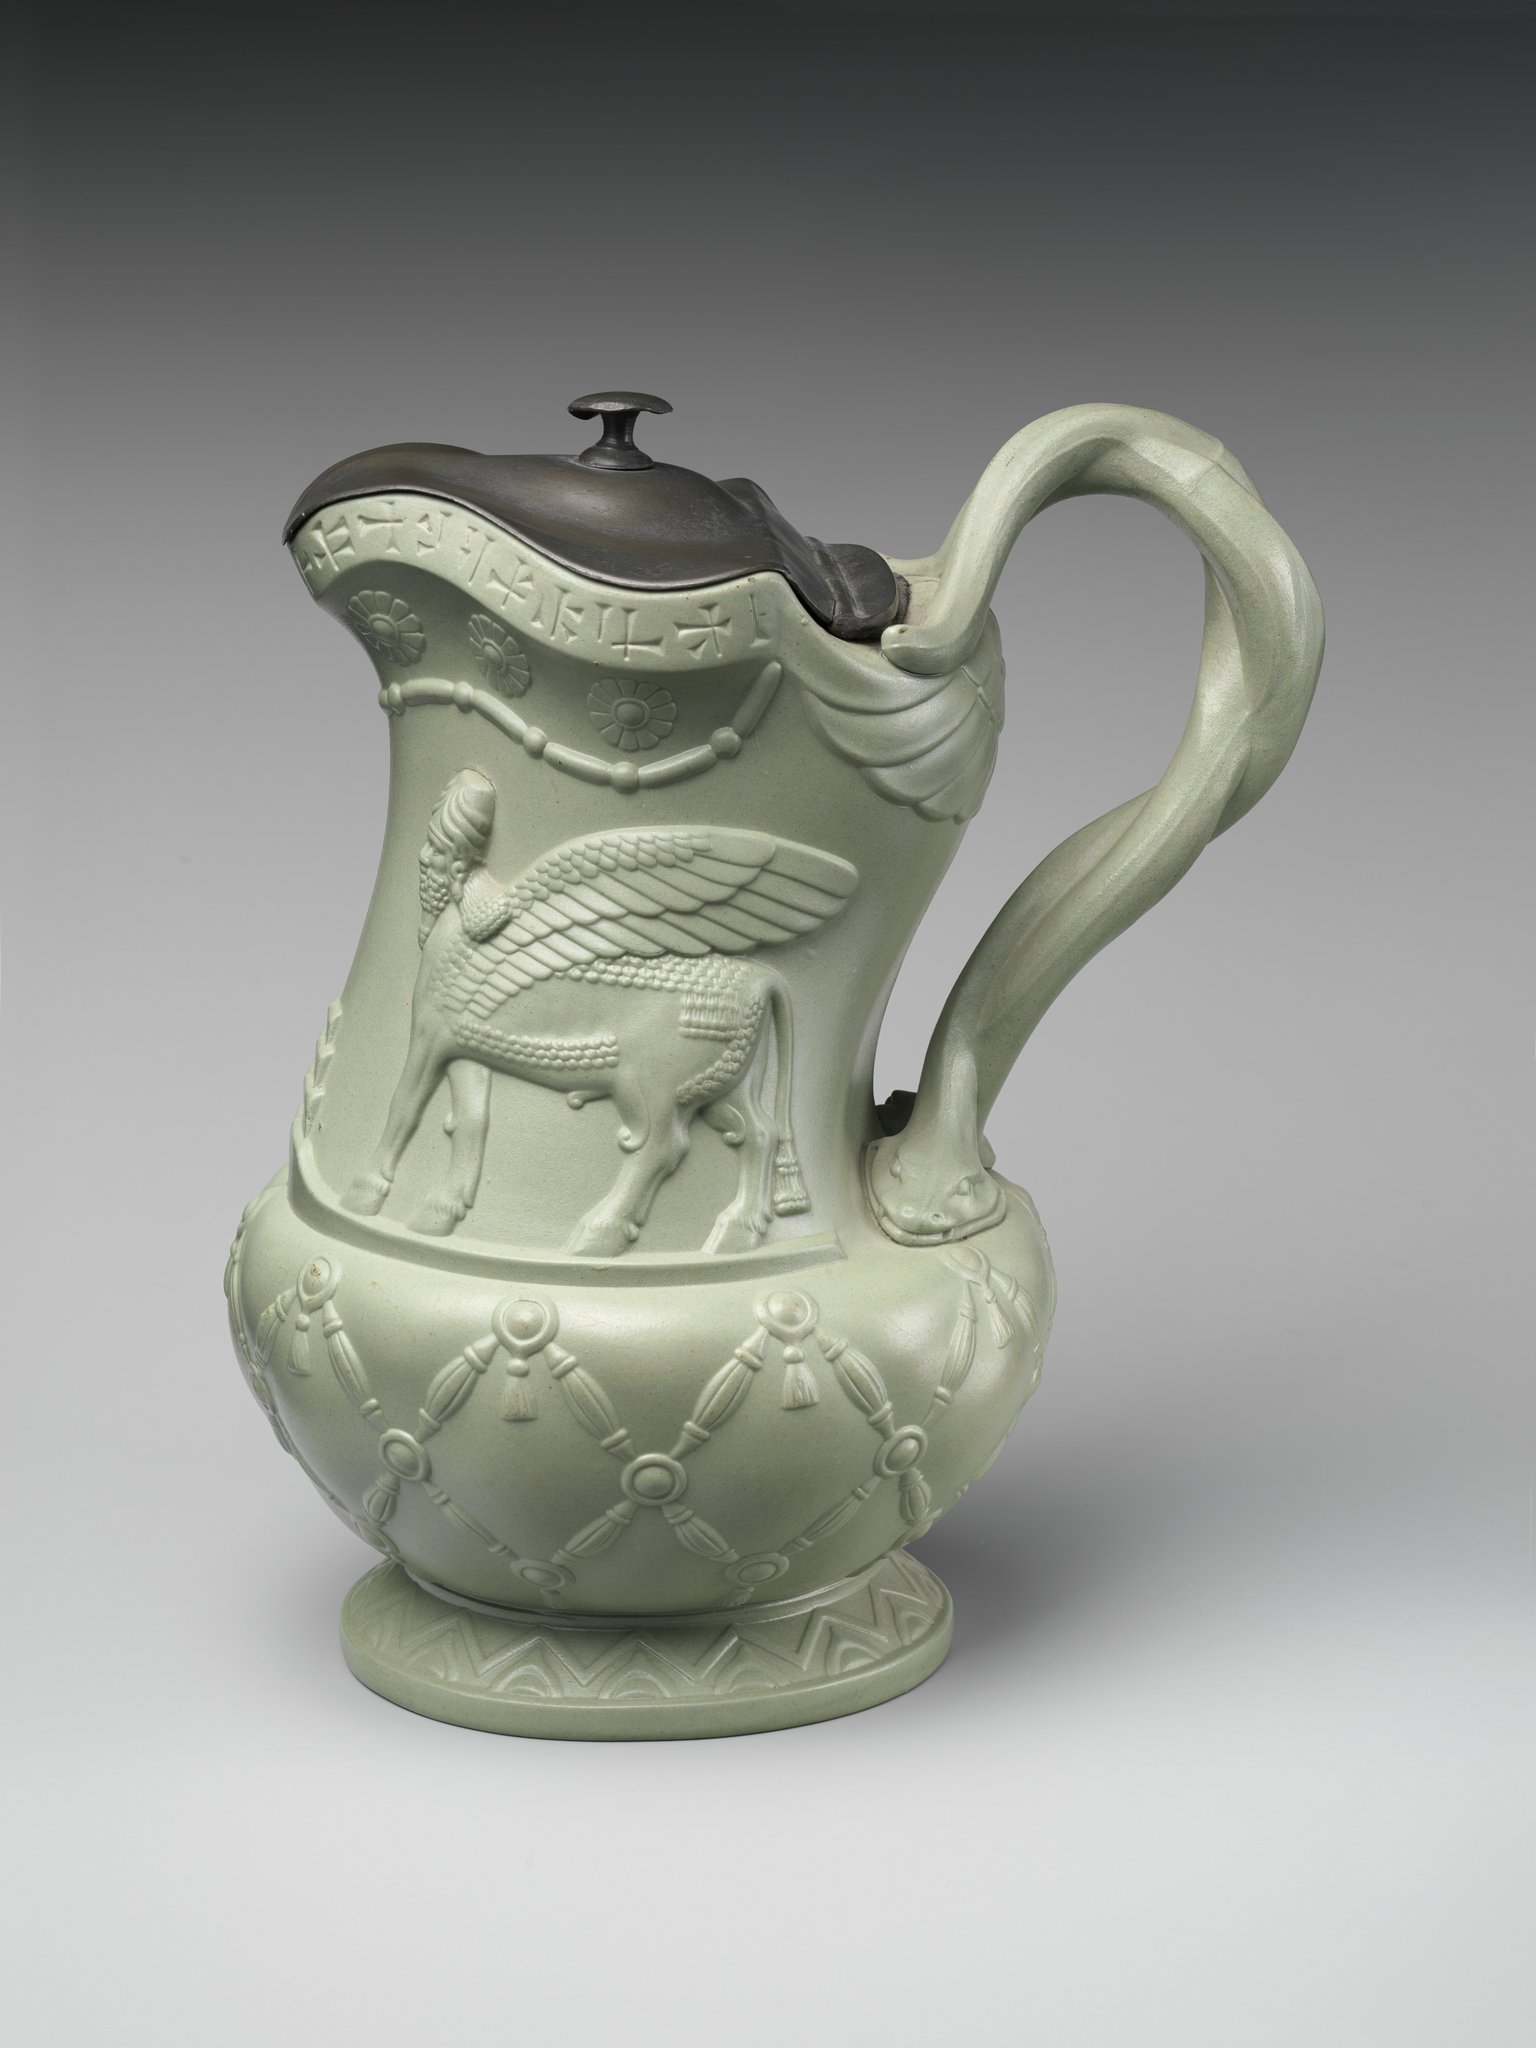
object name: jug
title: Jug with Assyrian-inspired decoration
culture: british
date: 1851-1860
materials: pewter, stoneware